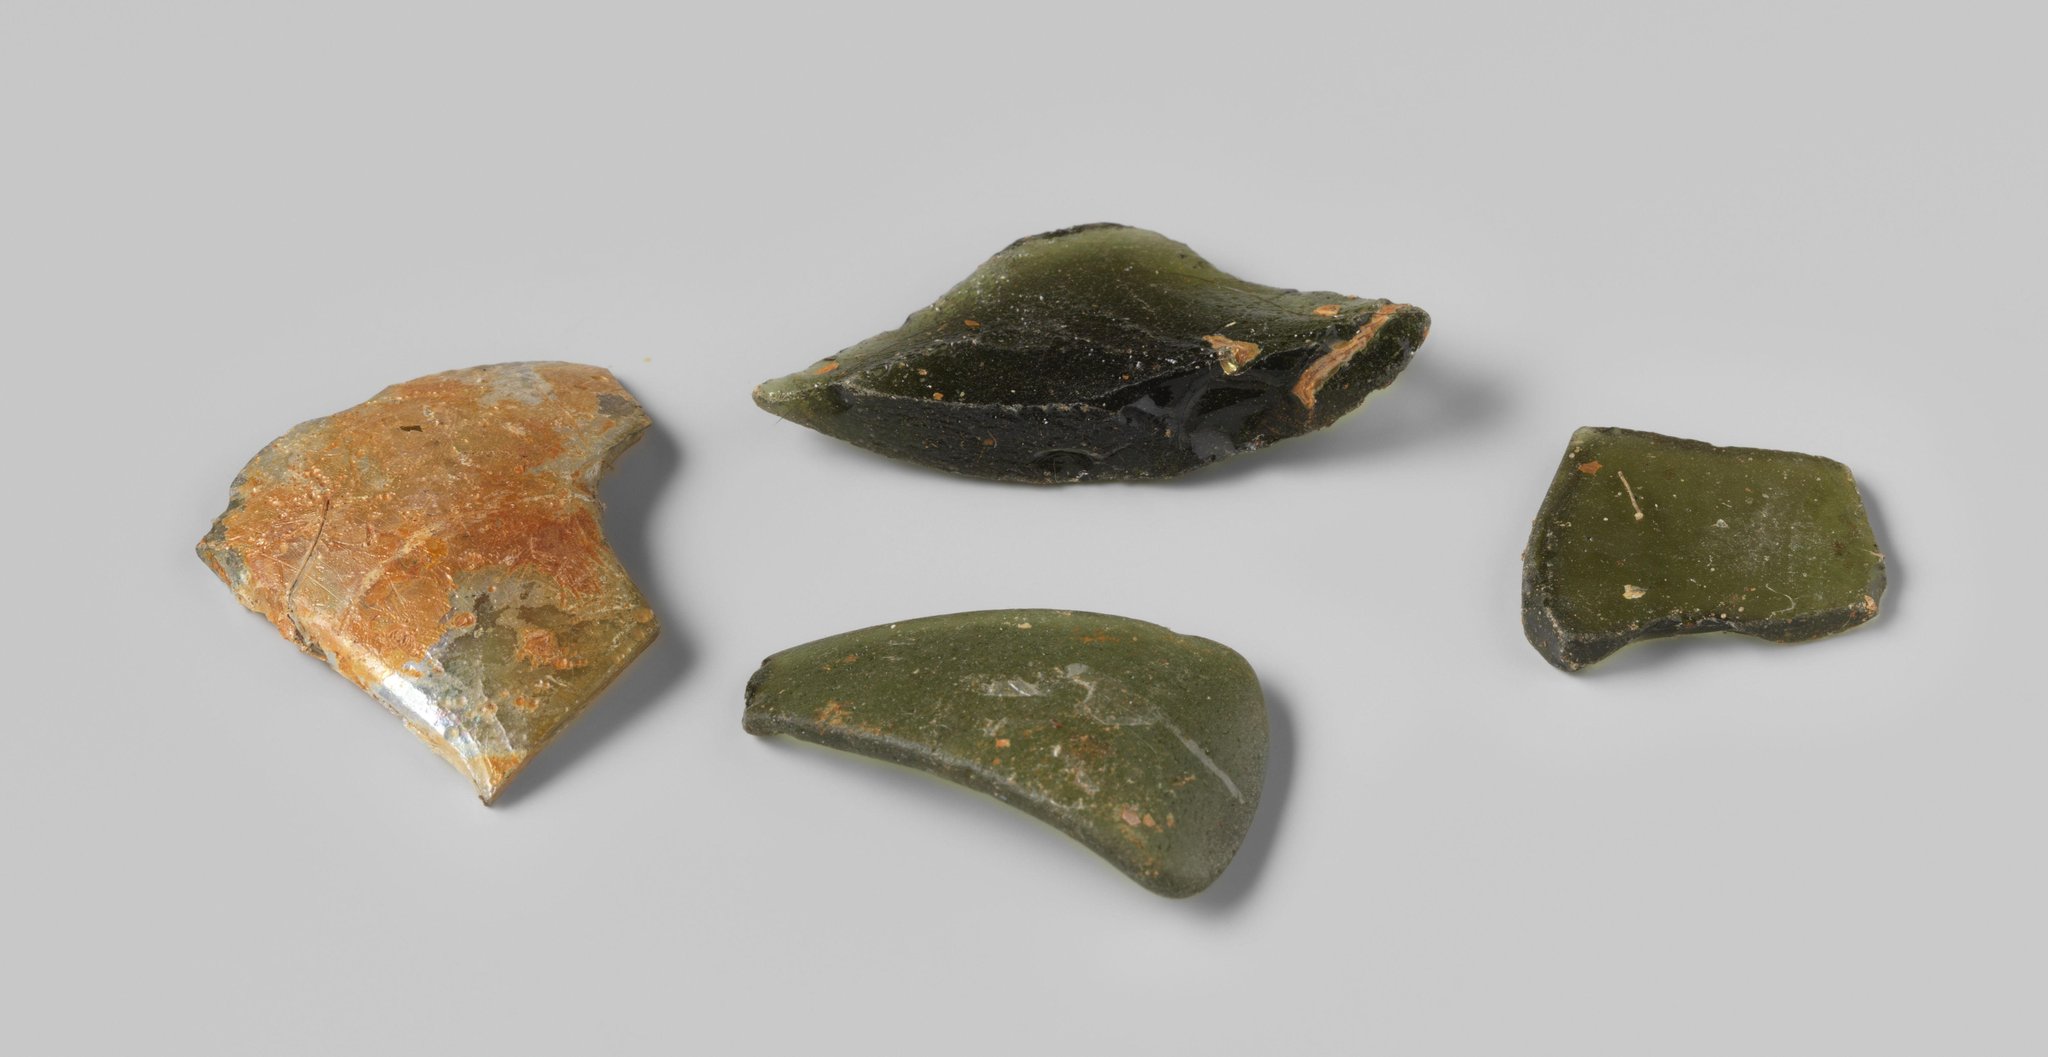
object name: sherd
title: Scherven van wijnflessen uit het wrak van de Oostindiëvaarder Hollandia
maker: Anonymous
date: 1700-1743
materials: glass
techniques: green glass